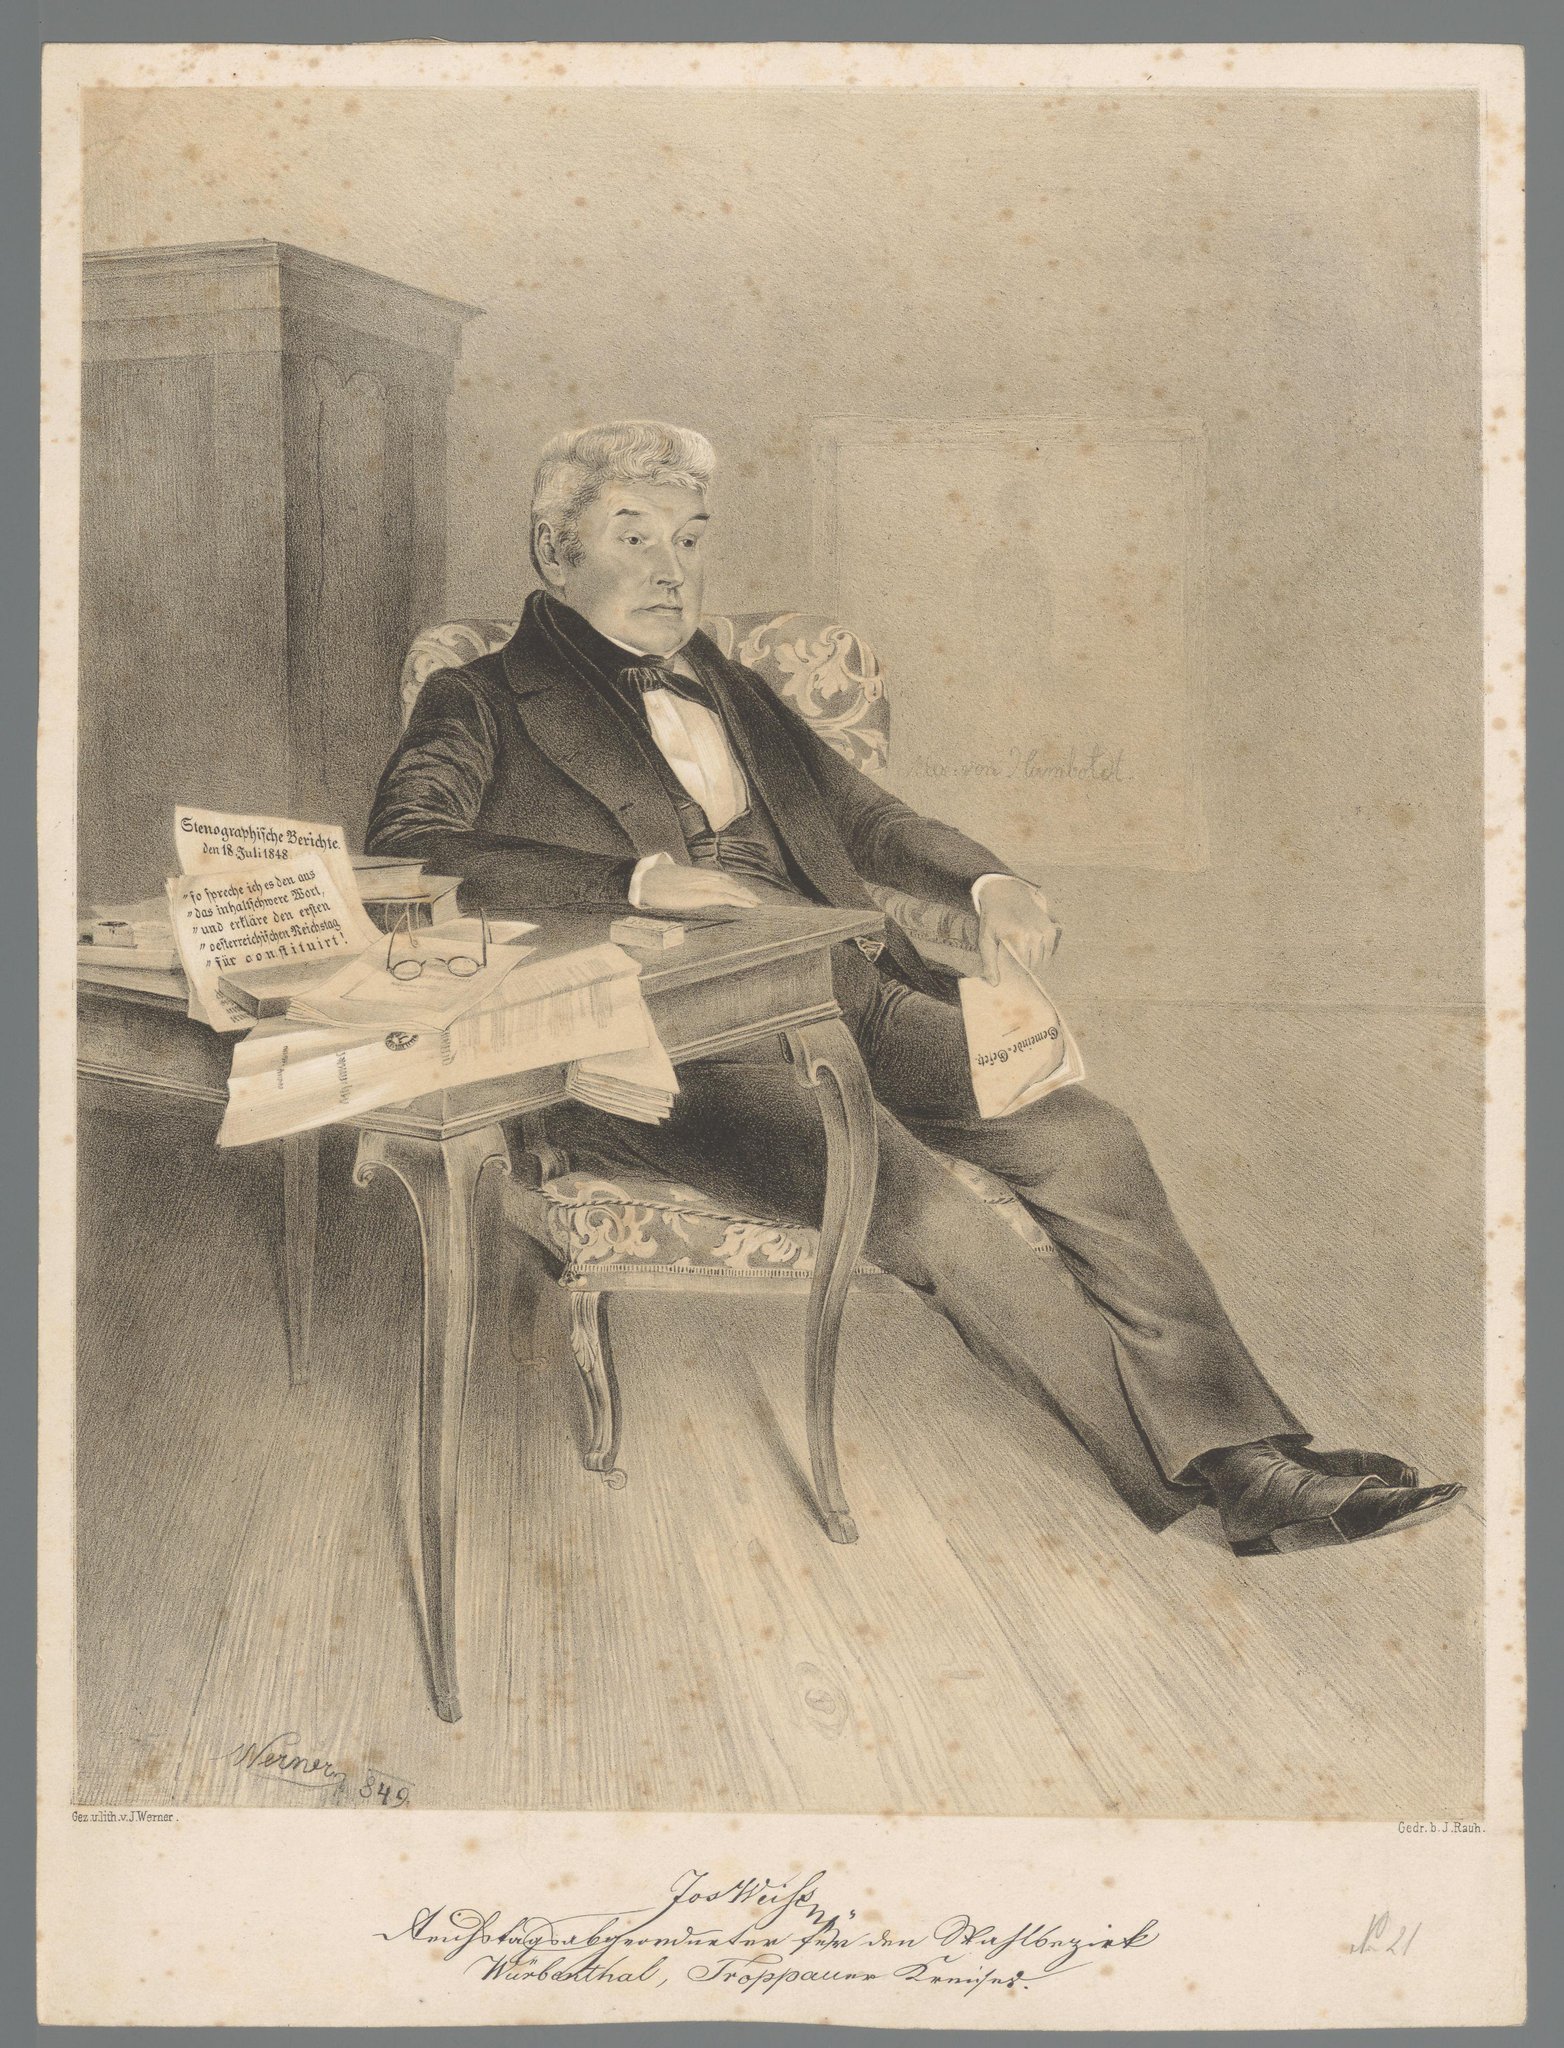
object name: print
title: Portret van Jos. Weiss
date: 1849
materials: paper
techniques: tone lithography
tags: adult man, historical persons, writing accessories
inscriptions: collector's mark: Lugt 2228